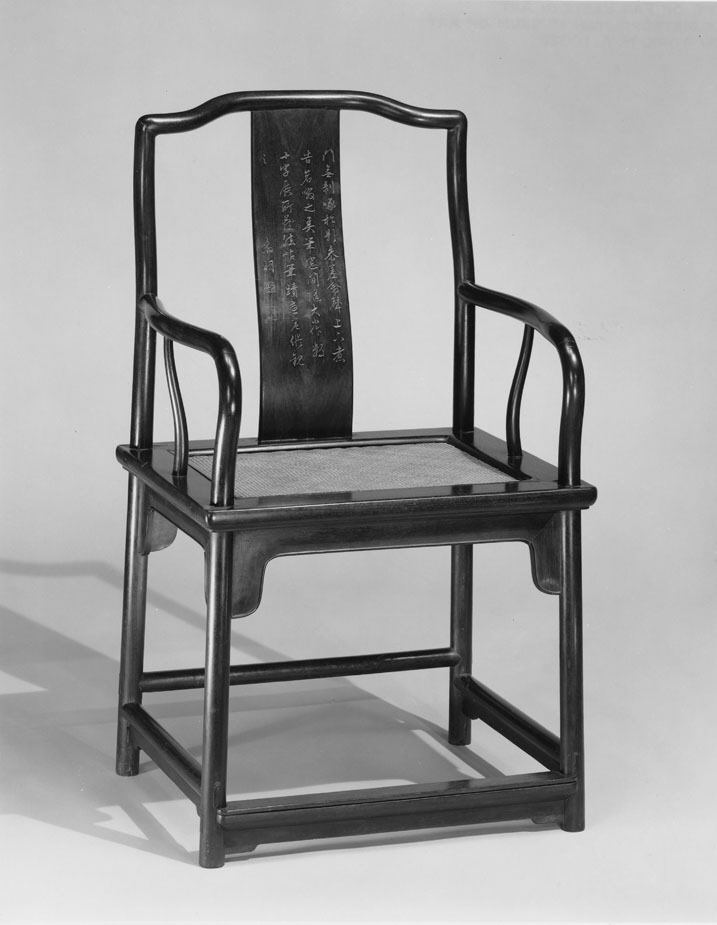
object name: armchair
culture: chinese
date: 1601-1700